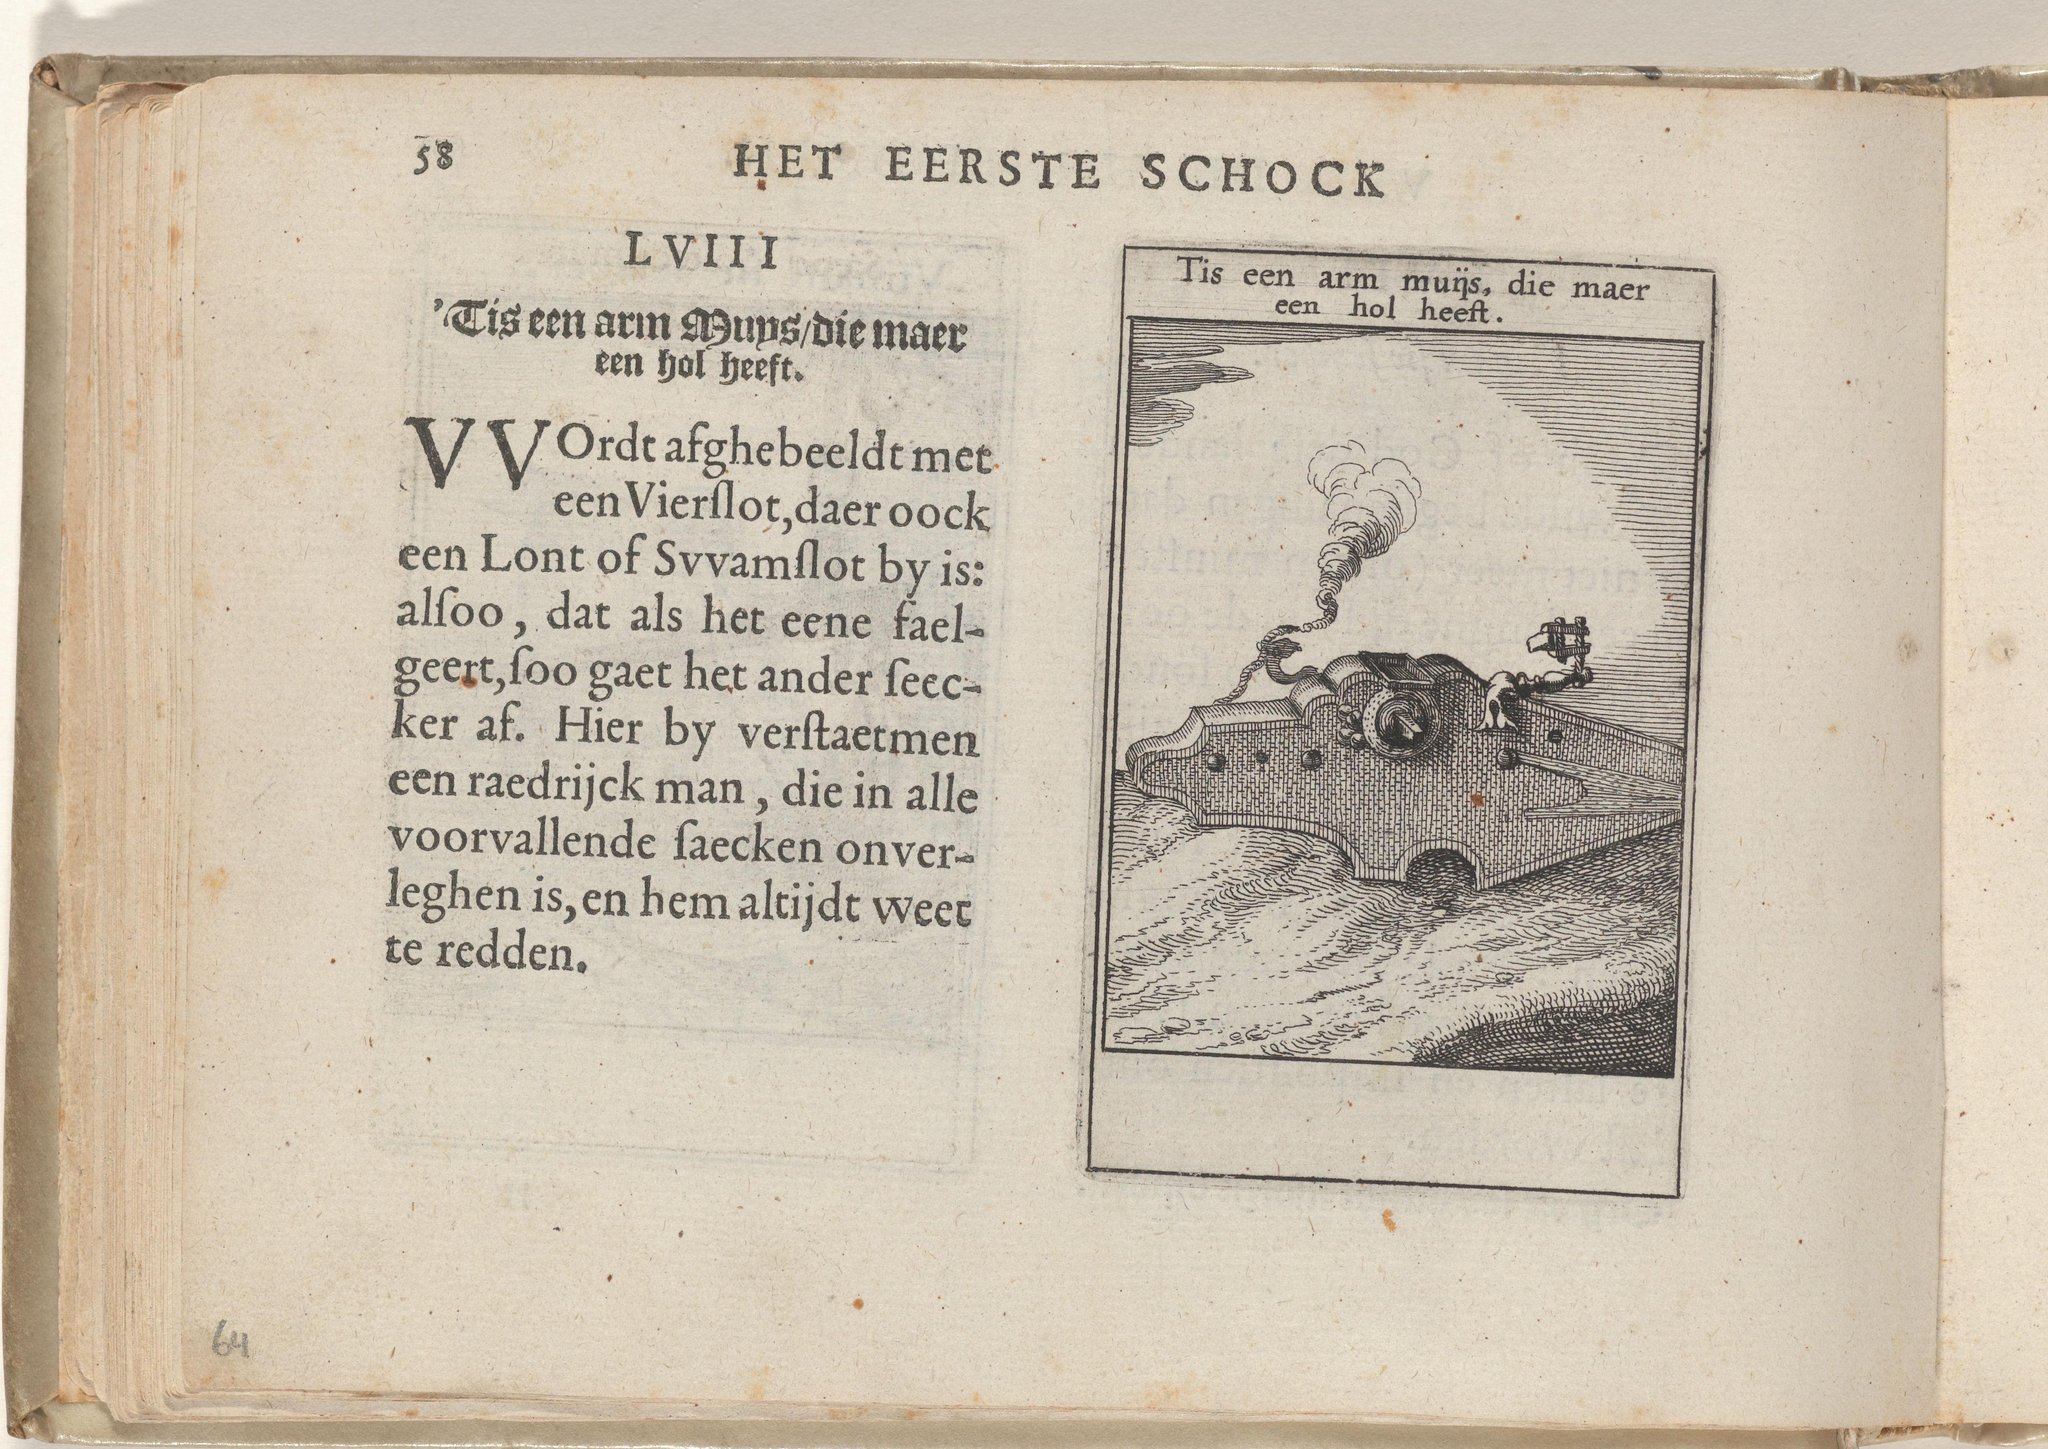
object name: album leaf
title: LVIII Tis een arm muijs, die maer een hol heeft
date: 1614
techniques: engraving, printing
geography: amsterdam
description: LVIII Tis een arm muijs, die maer een hol heeft. Eerste schok. Onderdeel van 'Sinnepoppen', R. Visscher, 1614.